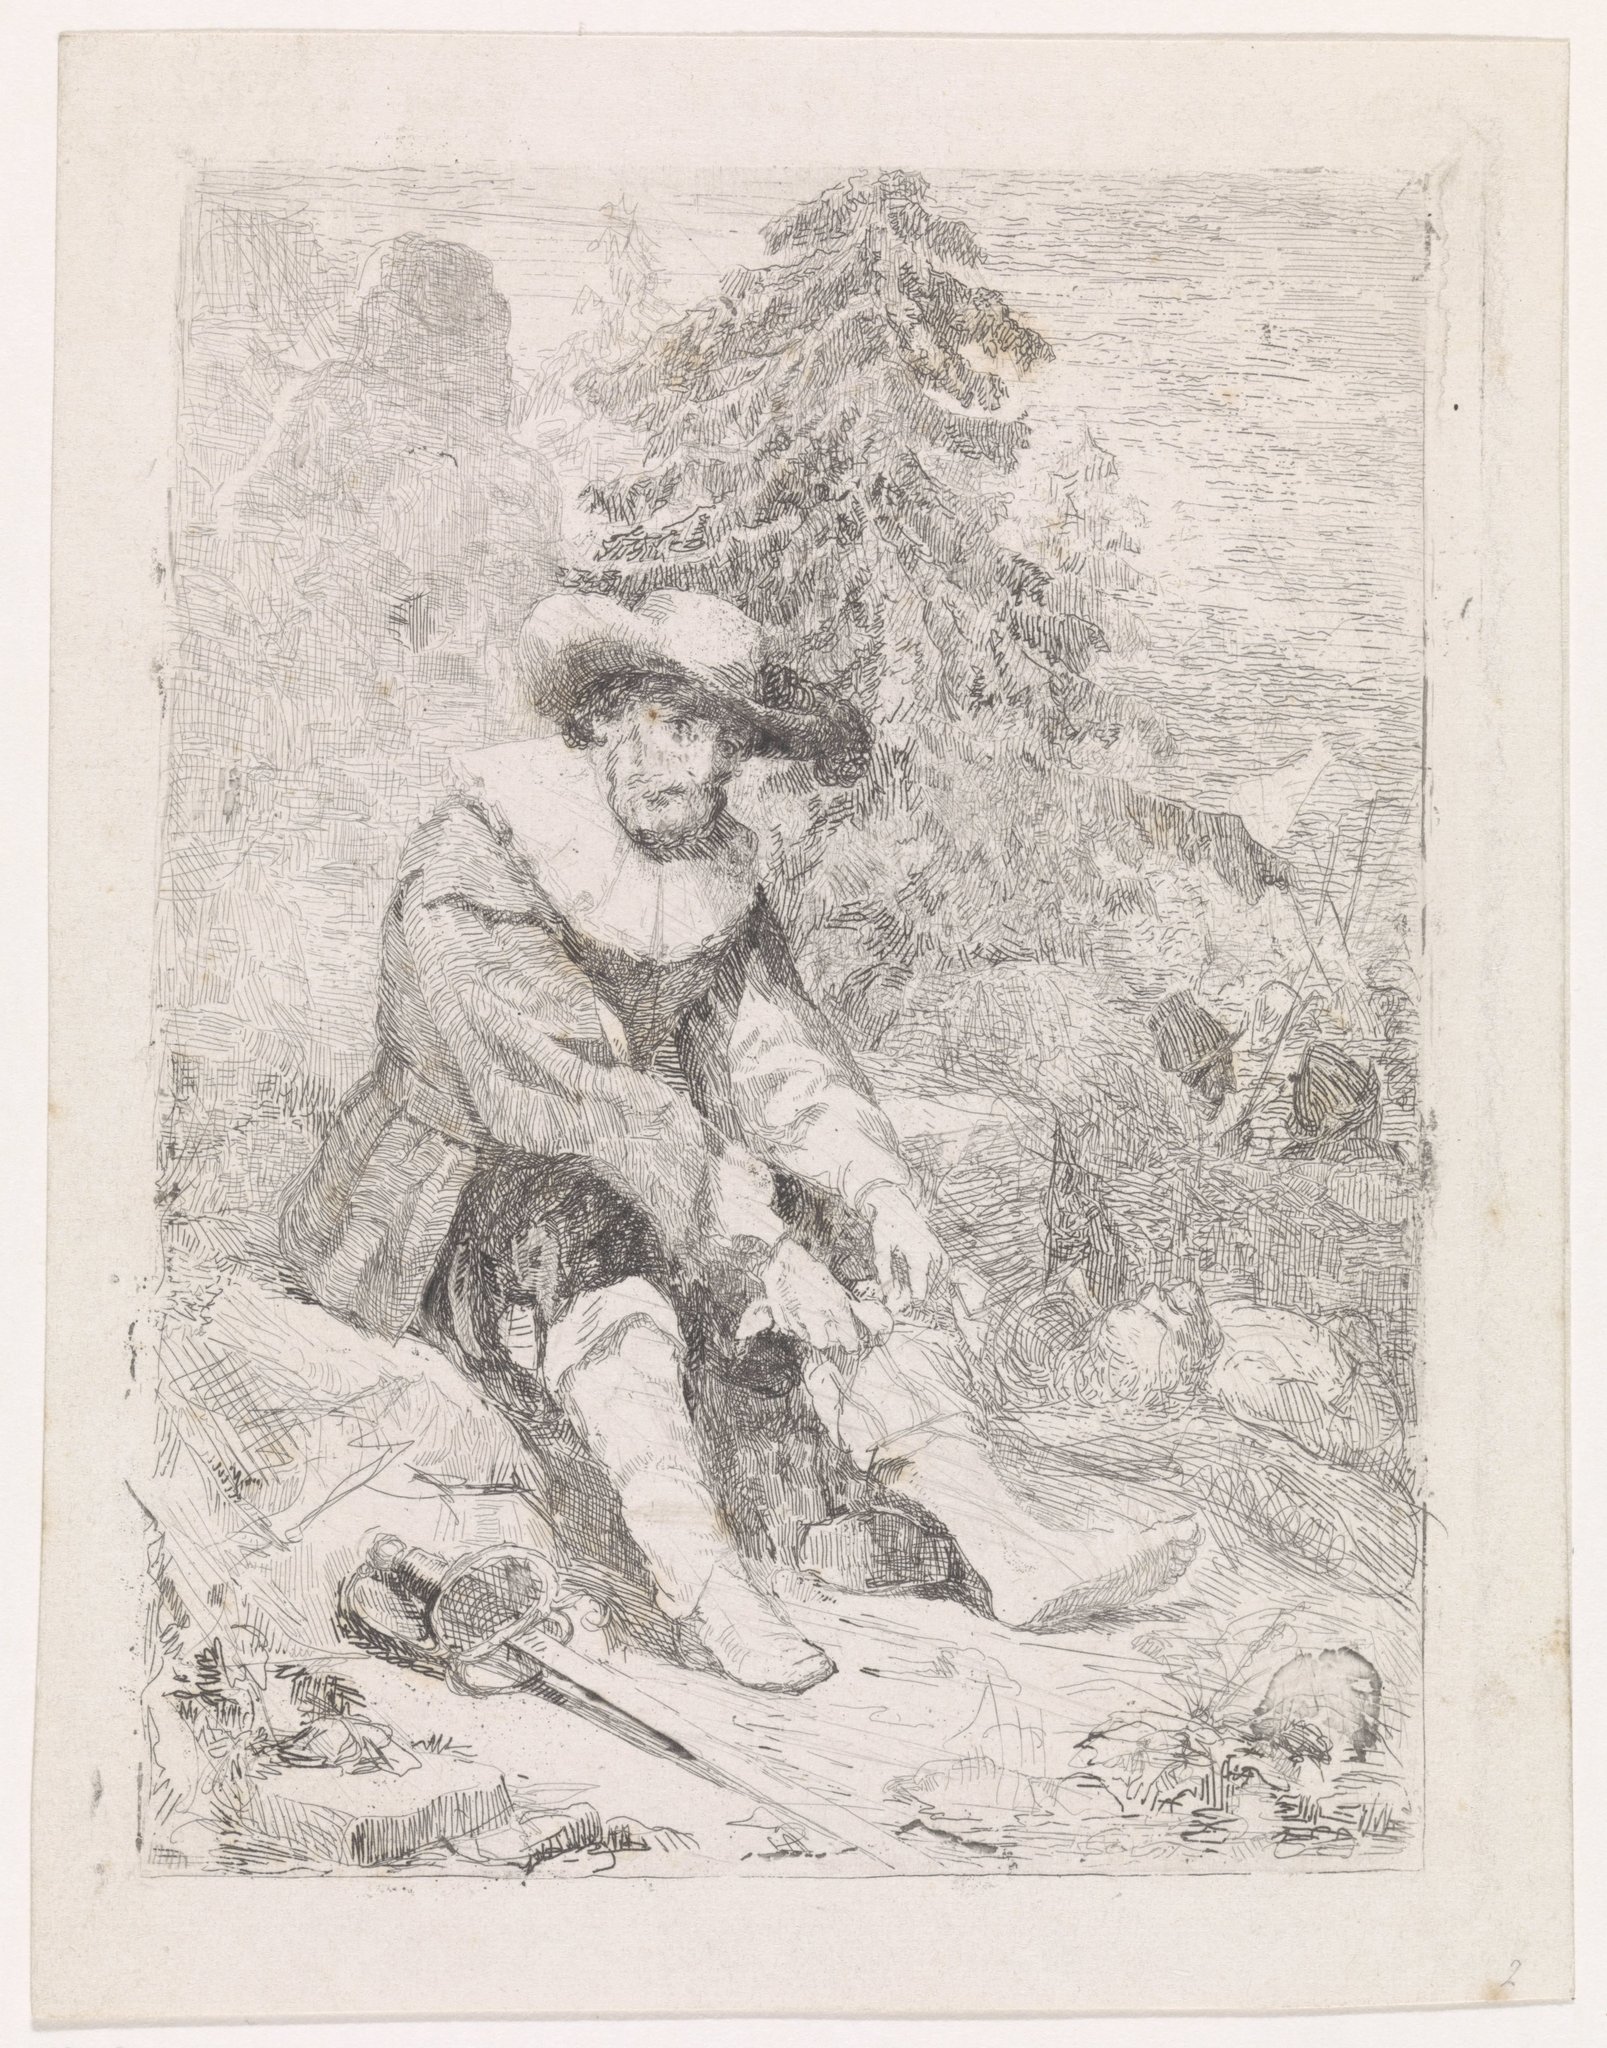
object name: print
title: Gewonde krijgsman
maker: david van der kellen (1827-1895)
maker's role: draughtsman, print maker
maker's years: 1827-1895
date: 1837-1886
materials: paper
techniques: drypoint, etching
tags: landscapes, hacking and thrusting weapons, infections and wounds, the soldier; the soldier's life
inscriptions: collector's mark: Lugt 1485, collector's mark: Lugt 2228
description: In een landschap verbindt een krijgsman zijn gewonde linkerbeen. Rechts naast hem ligt het levenloze lichaam van een soldaat, en links zijn rapier. Op de achtergrond zijn enkele naaldbomen en de contouren van een verwoeste gevel te zien.